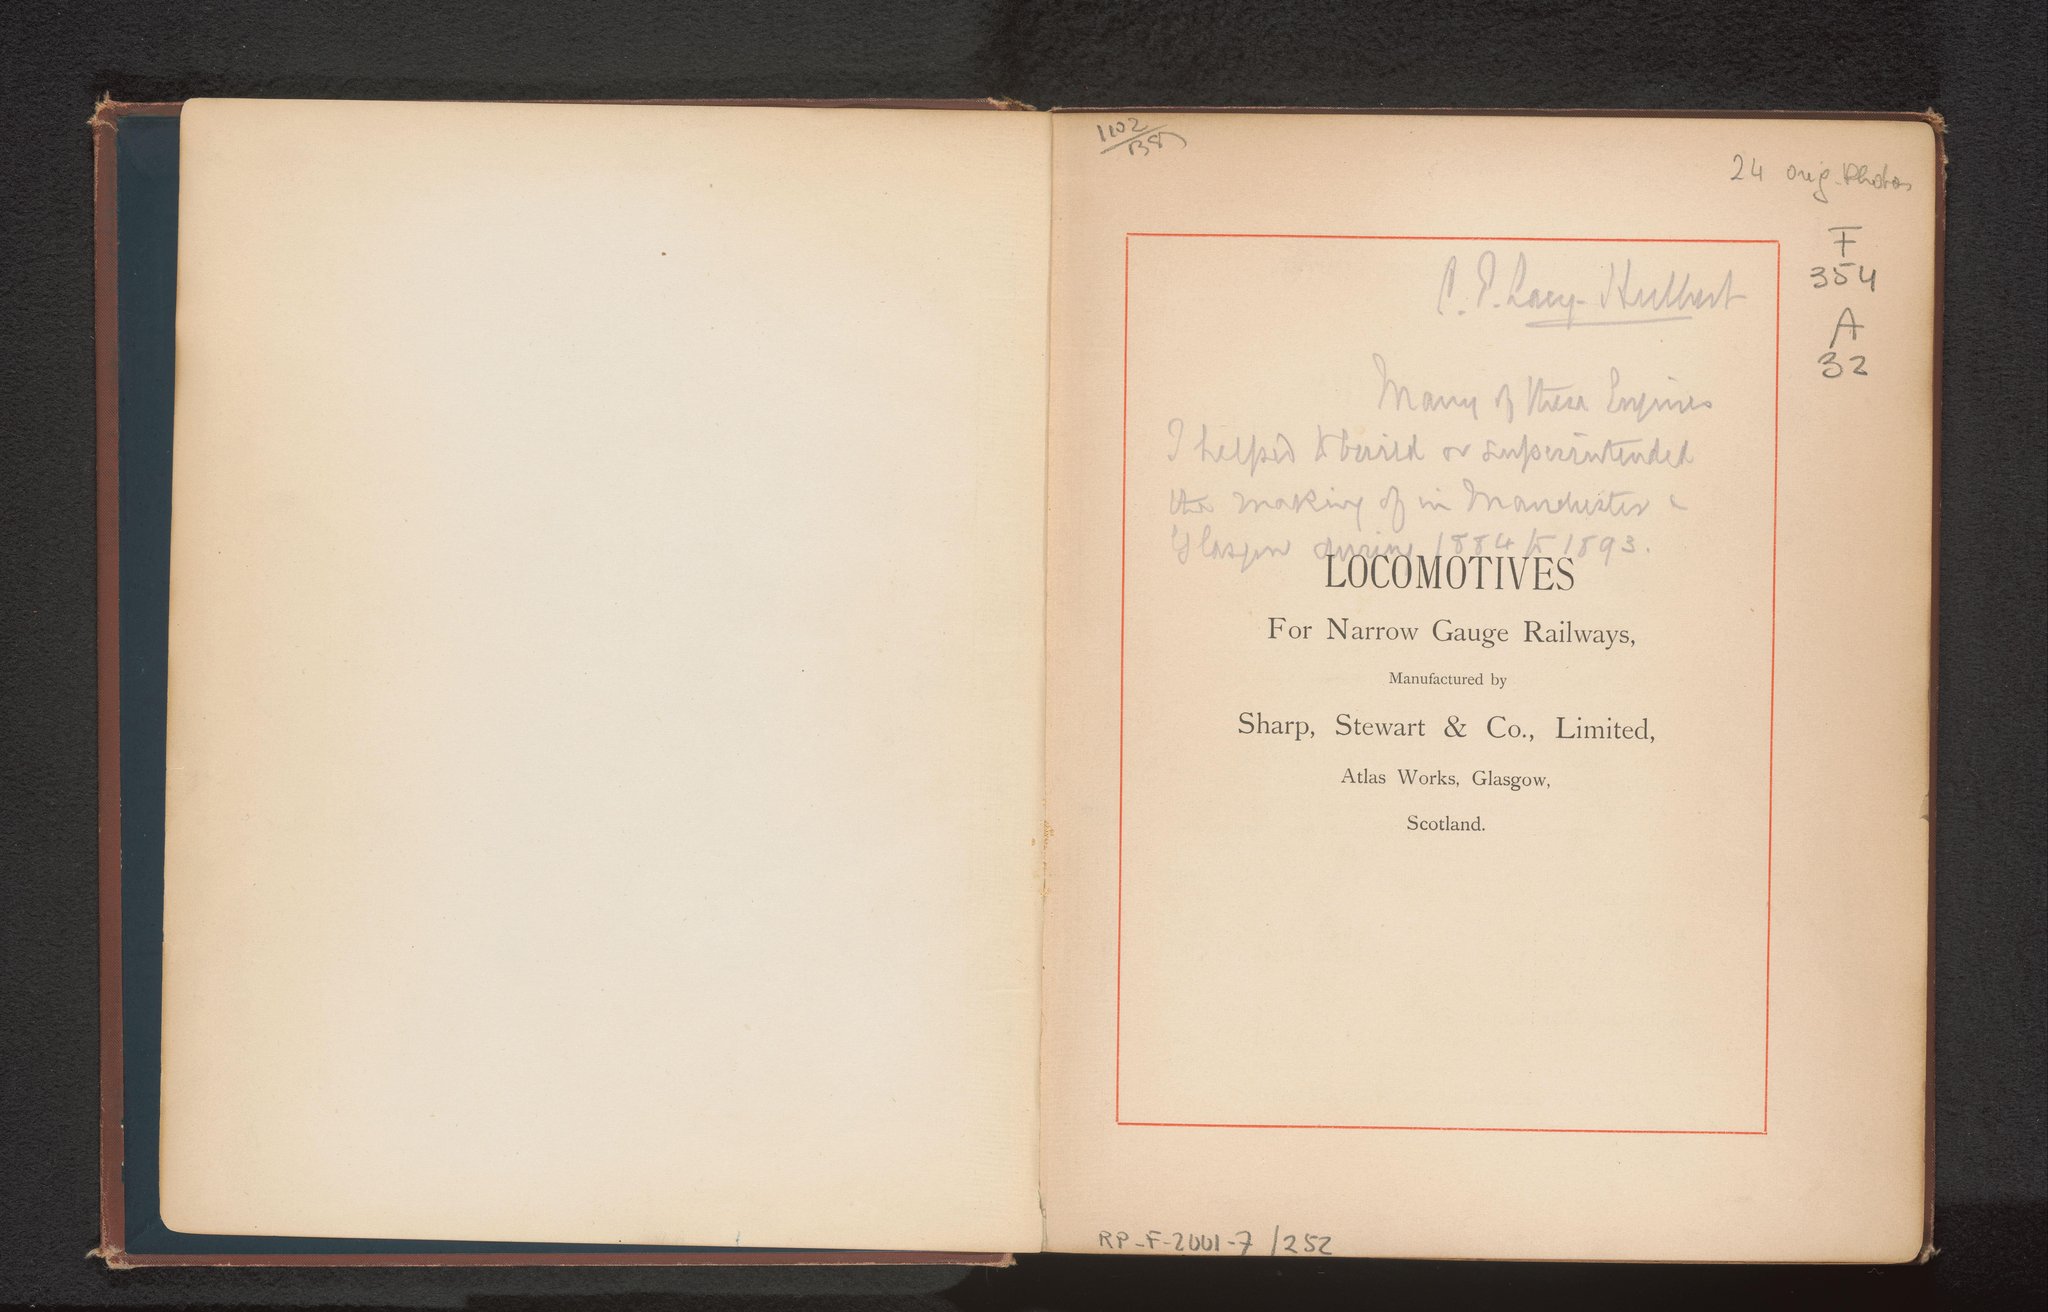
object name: book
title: Locomotives for narrow gauge railways manufactures by Sharp, Stewart and Co., Limited, Atlas Works, Glasgow, Scotland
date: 1884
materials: linen, paper, photographic support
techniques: albumen print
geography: glasgow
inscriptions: inscription: ‘C.P. Lary. Hulbert Many & [...] Engines I helped to build [...] 1884 to 1893’